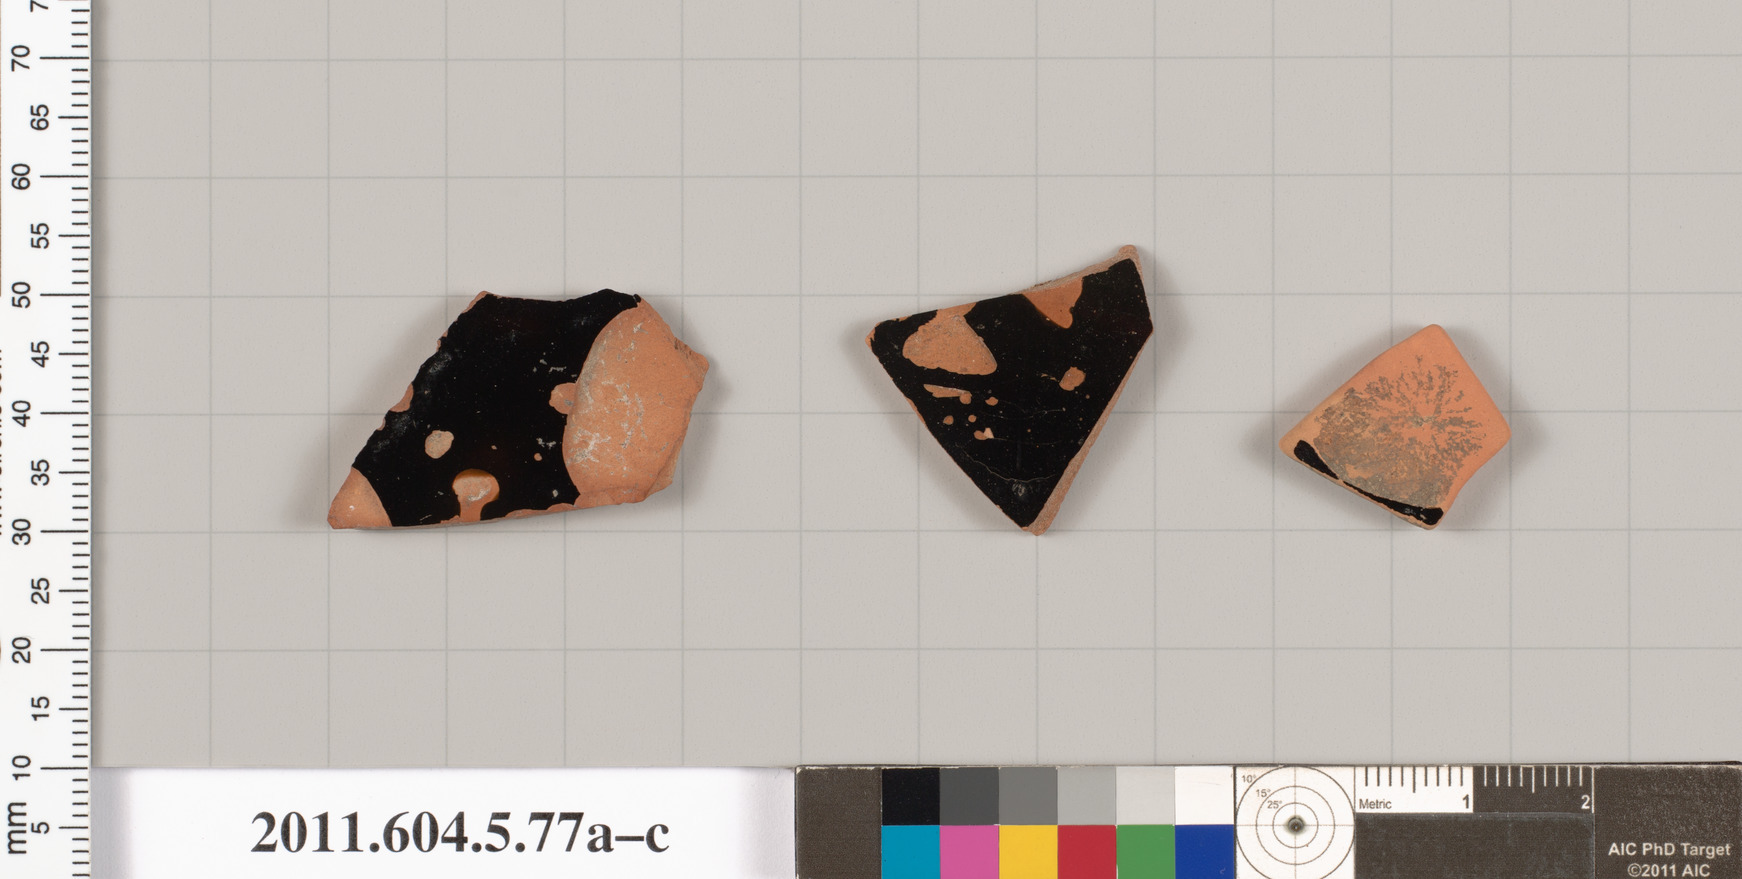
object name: kylix fragment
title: Terracotta fragments of kylikes (drinking cups)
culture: greek, attic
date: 500-451 BCE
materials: terracotta